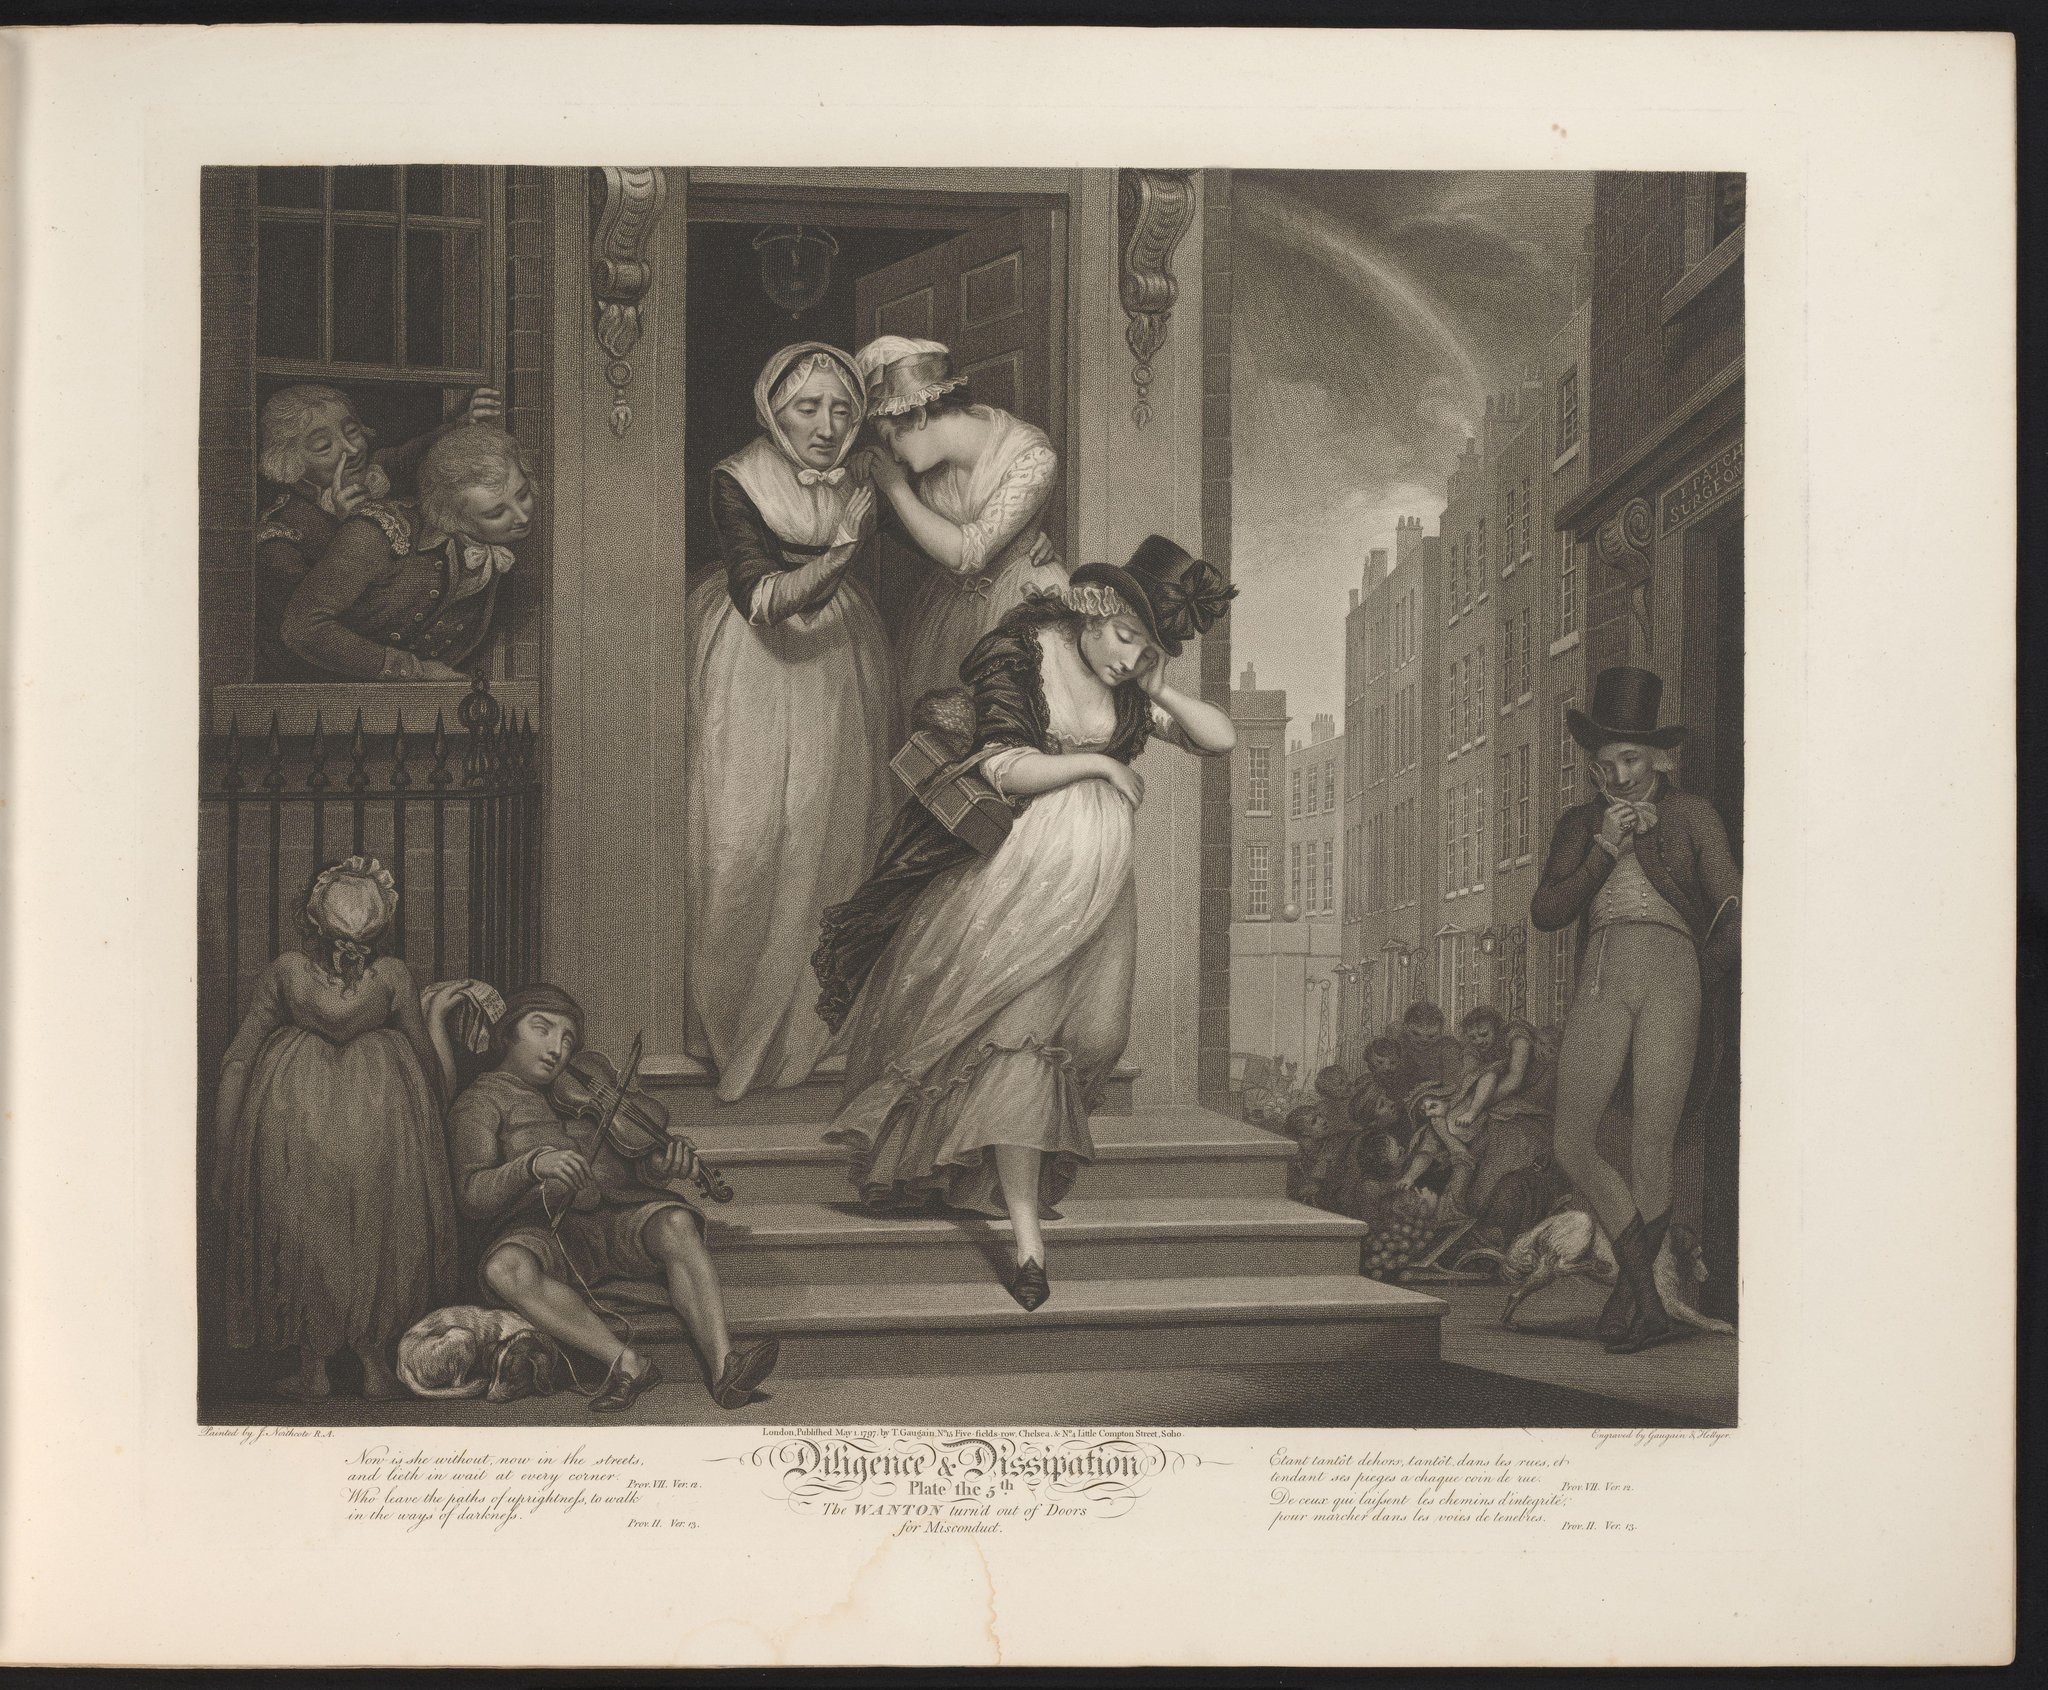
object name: print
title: Plate 5. The Wanton turn'd out of Doors for Misconduct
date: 1796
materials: paper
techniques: etching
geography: london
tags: good and bad behaviour, moral qualities (opposing concepts), chastity versus sensuality, good and bad behaviour, moral qualities, unemployment - aa - women, proverbs, sayings, etc., maid ~ house personnel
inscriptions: collector's mark: Lugt 2760, collector's mark: Lugt 2228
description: De losbandige dienstmaagd moet het huis verlaten, uitgeleide gedaan door de oude dienster en de nijvere dienstmaagd. Links bevinden zich een blinde straatmuzikant en een lootjesverkoopster, rechts is een vechtpartij gaande en staat een jongeman met lorgnet. De prent maakt deel uit van een album.